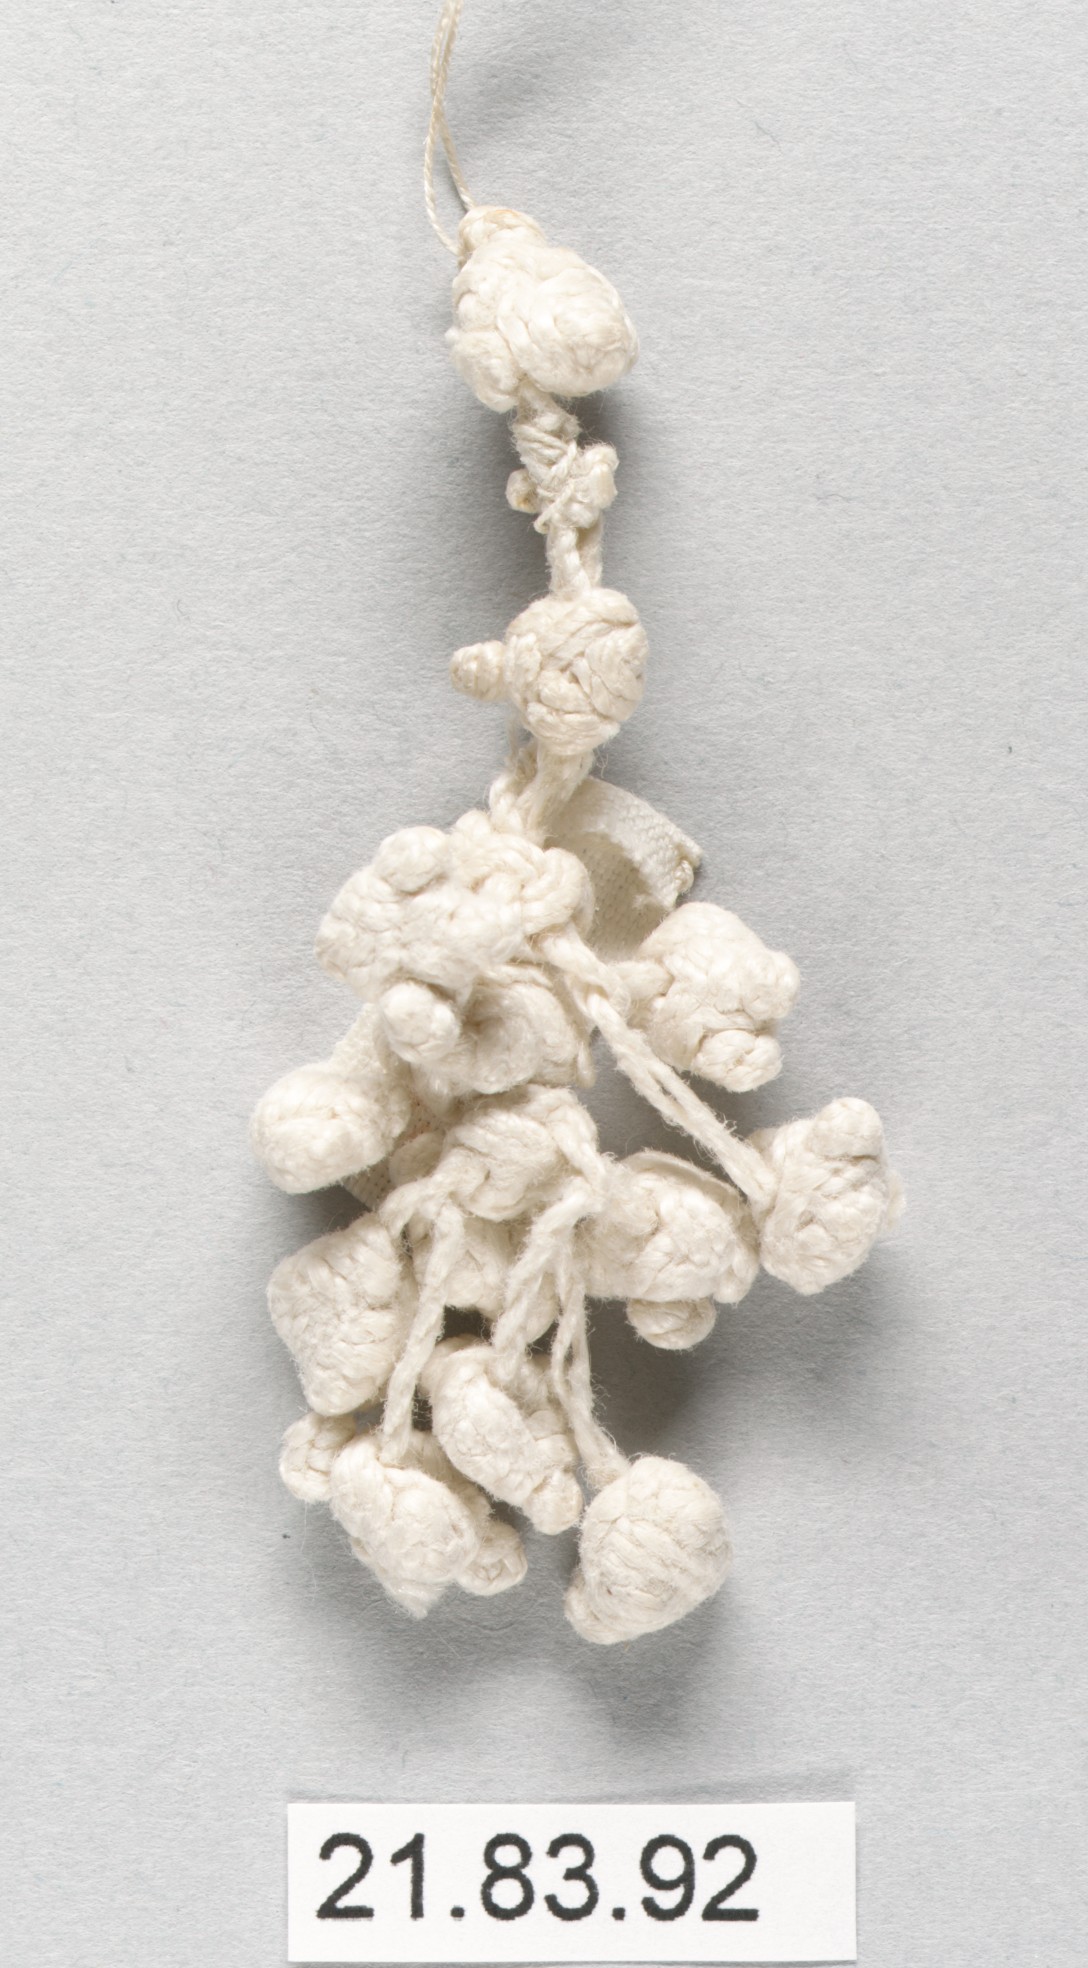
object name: tassel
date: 1601-1700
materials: linen